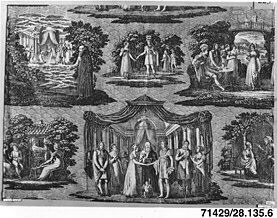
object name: furnishing textile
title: La Trève de Dieu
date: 1820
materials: cotton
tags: men,women,trees